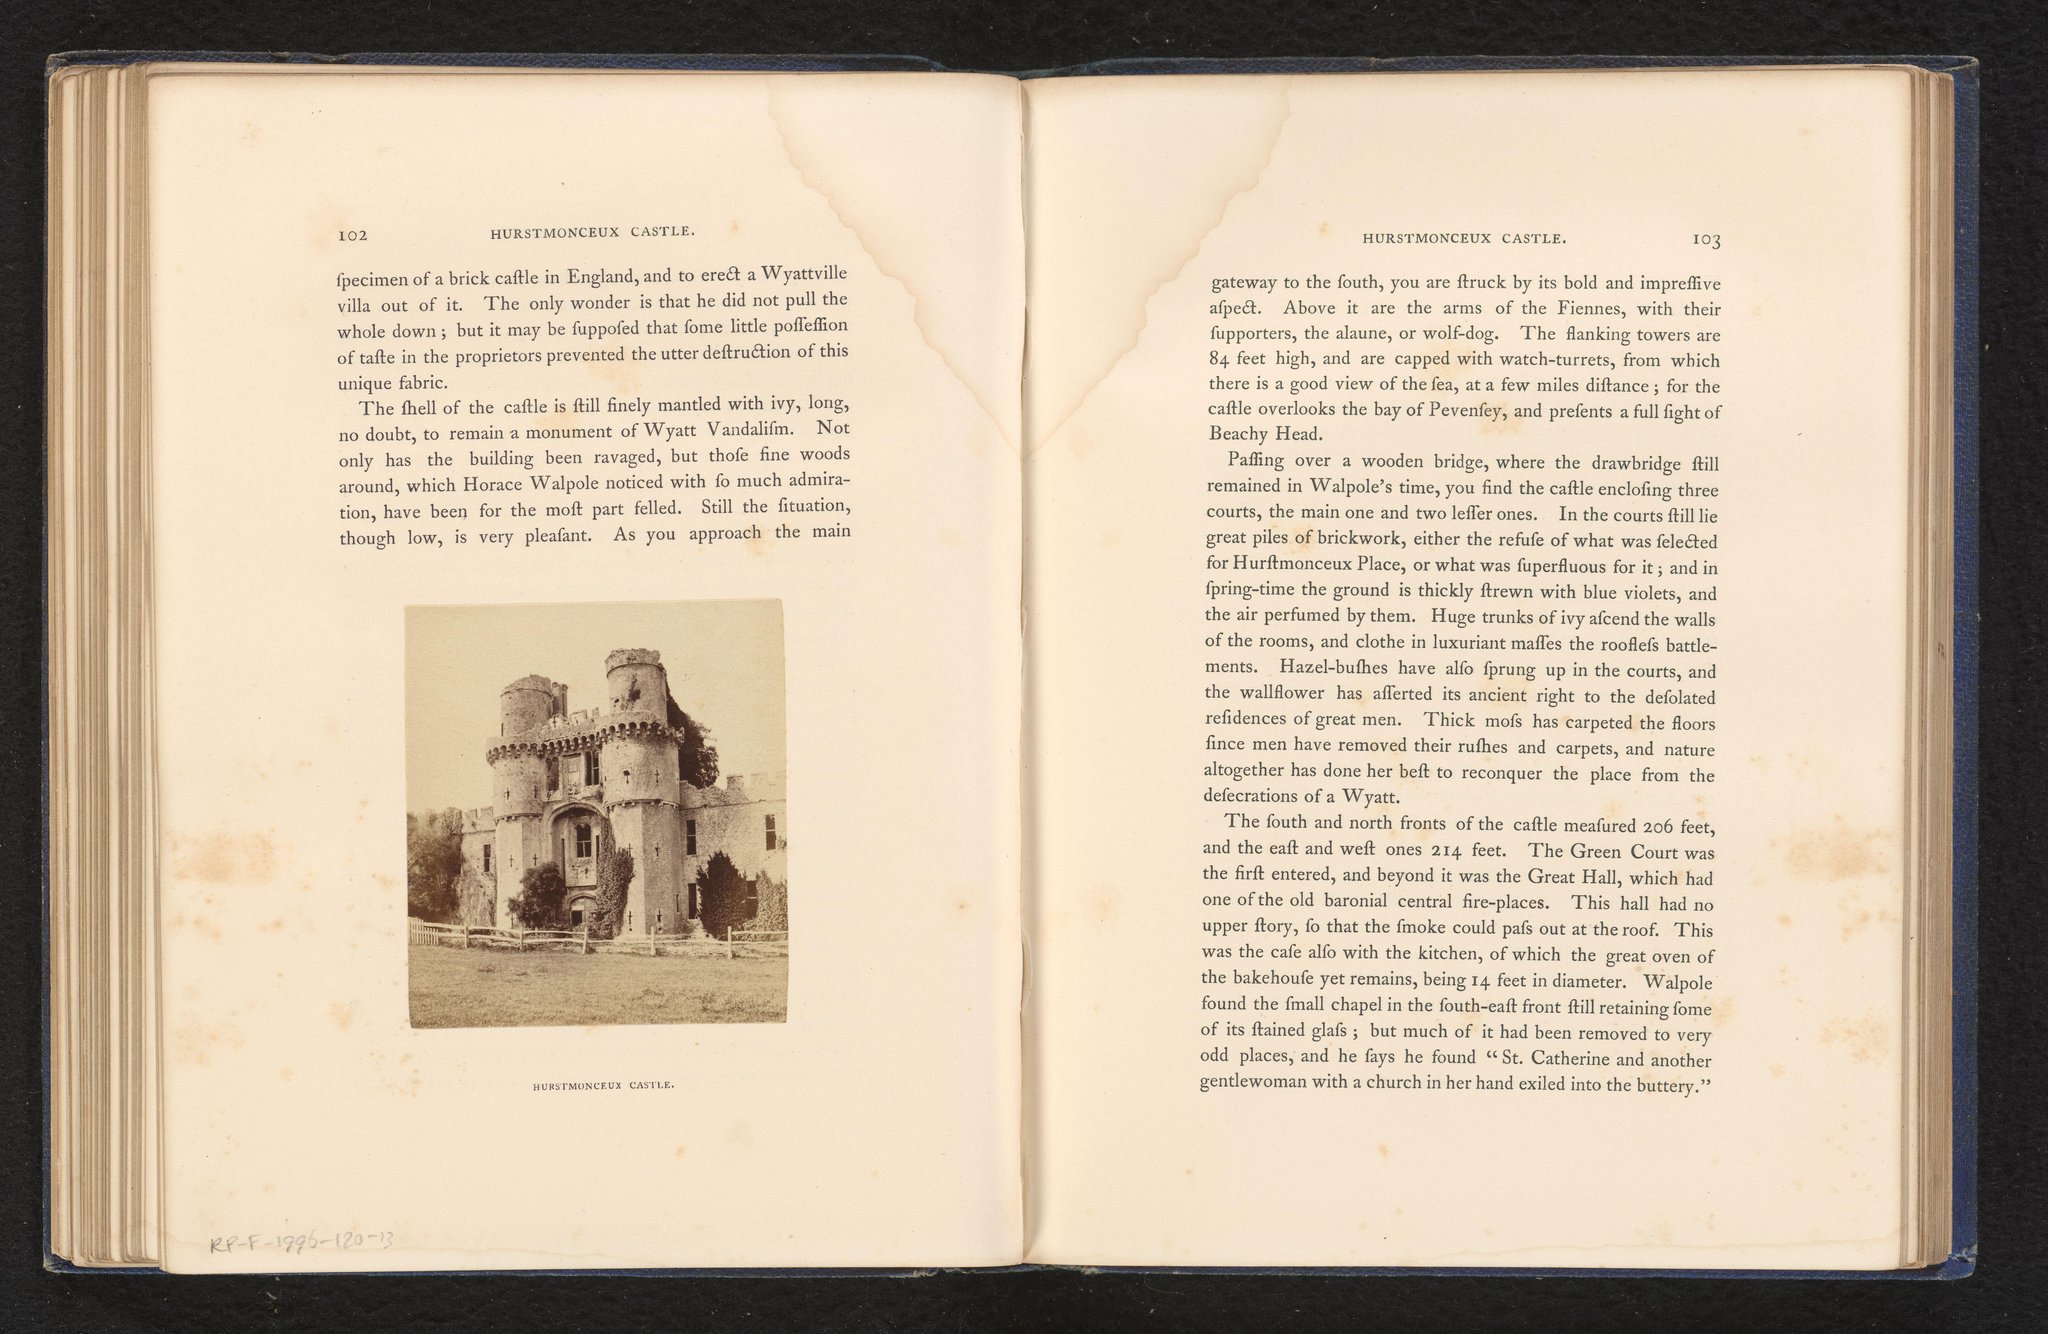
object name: photograph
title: Gezicht op Herstmonceux Castle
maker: william russell sedgfield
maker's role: fotograaf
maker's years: 1826-1902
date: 1859-1864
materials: paper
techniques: albumen print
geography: herstmonceux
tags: castle